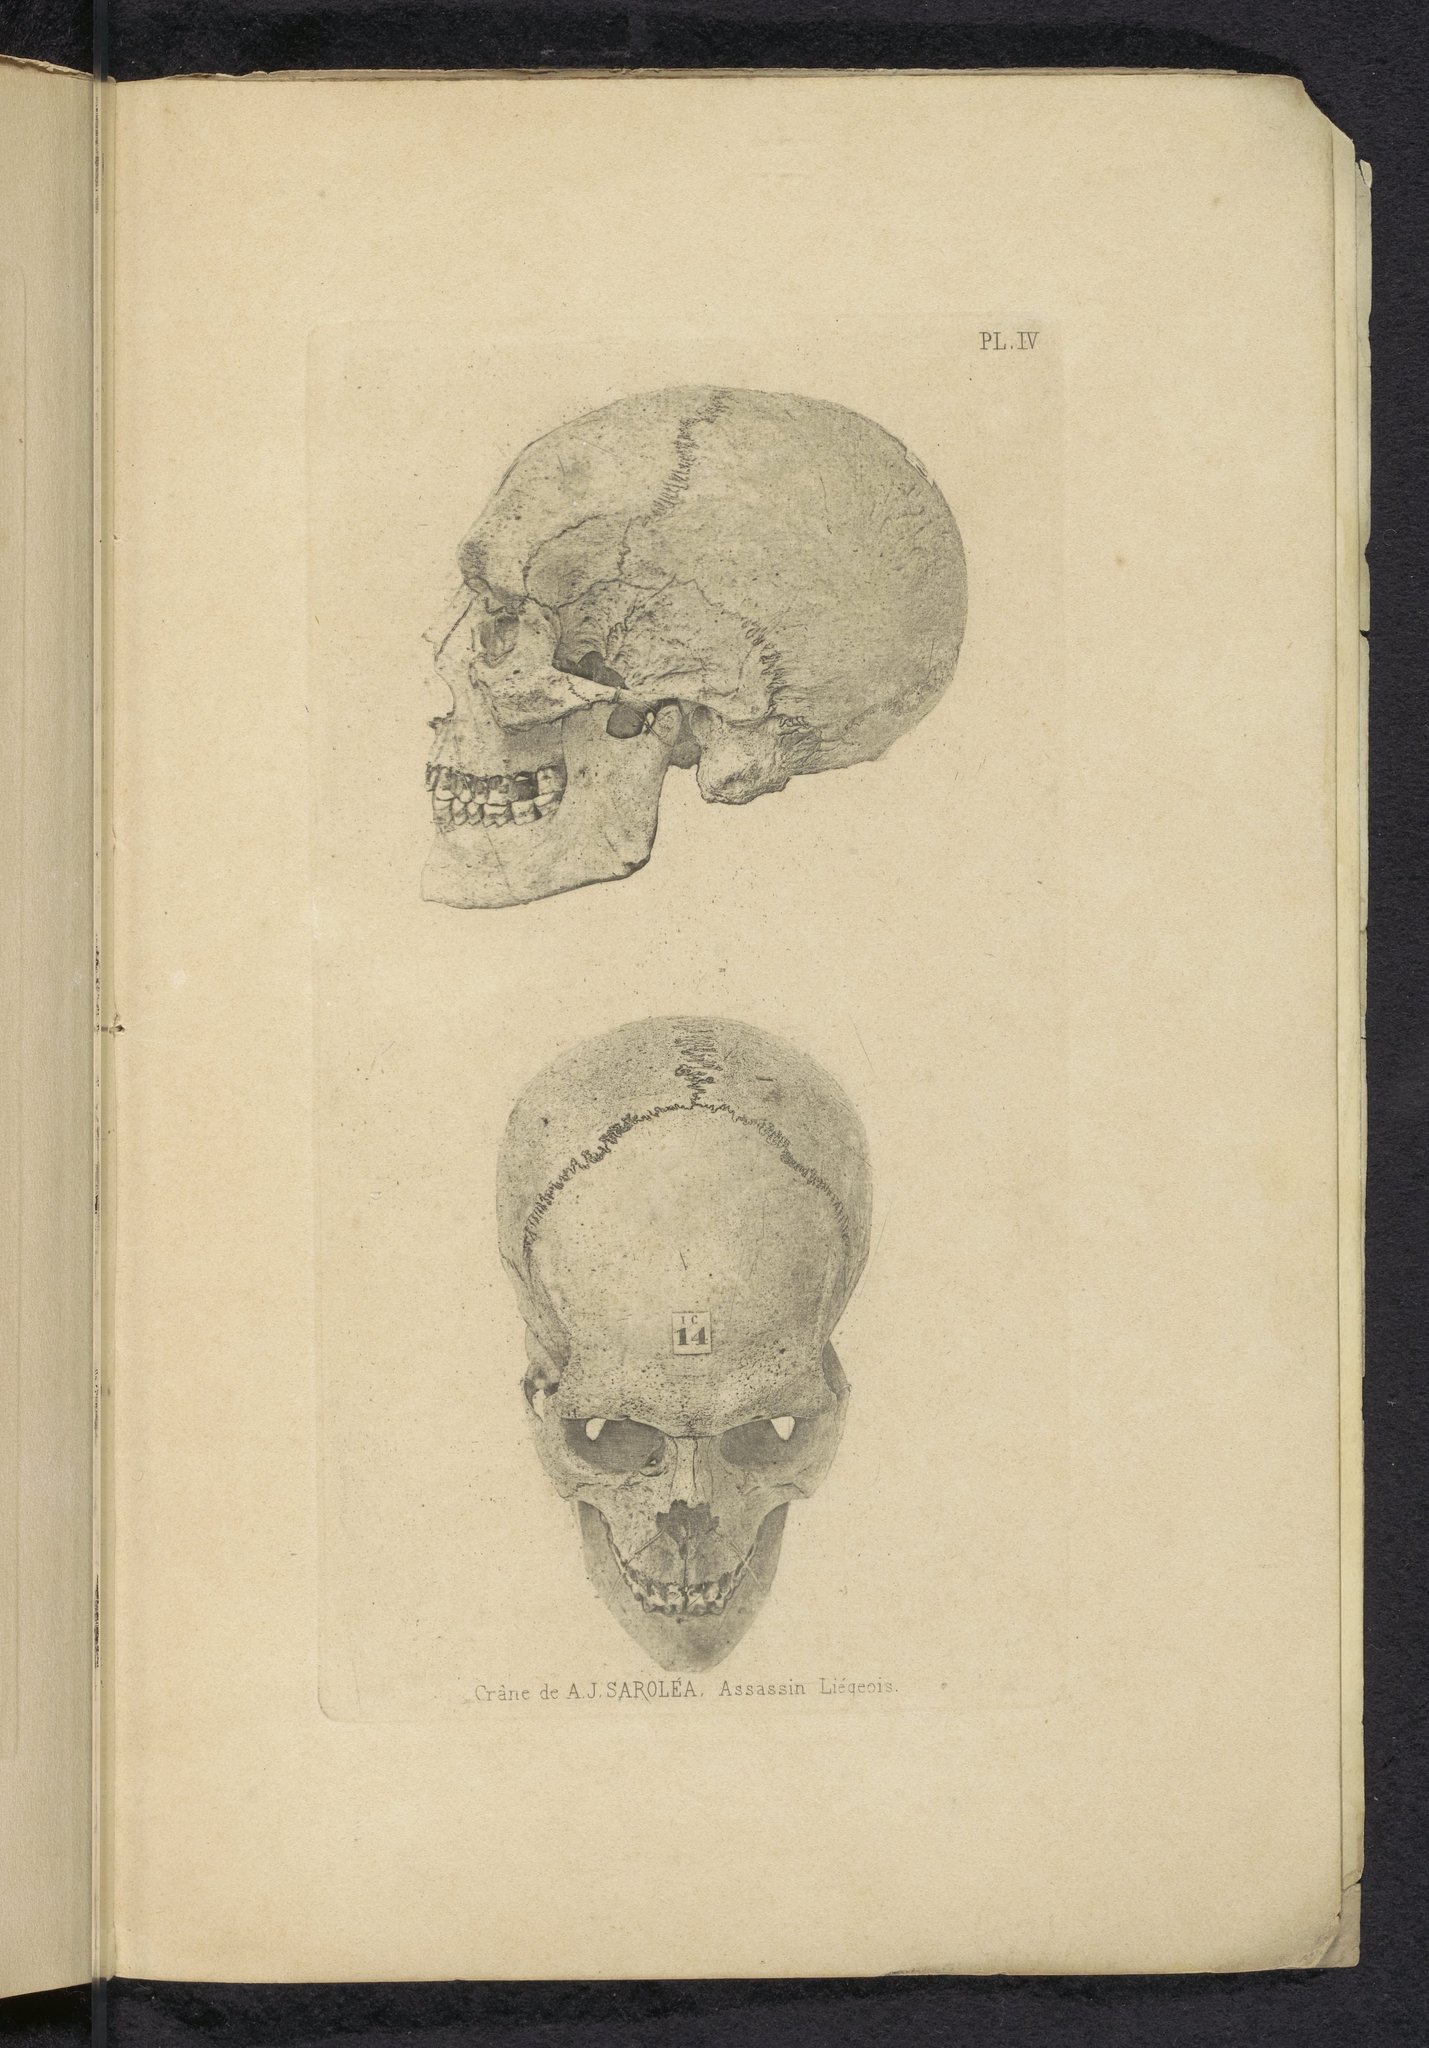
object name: page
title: Crâne de A.J. Saroléa assassin Liégeois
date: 1871-1881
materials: paper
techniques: photoaquatint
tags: (human) skull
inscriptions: number: ‘PL. IV.’, inscription: ‘IC 14’